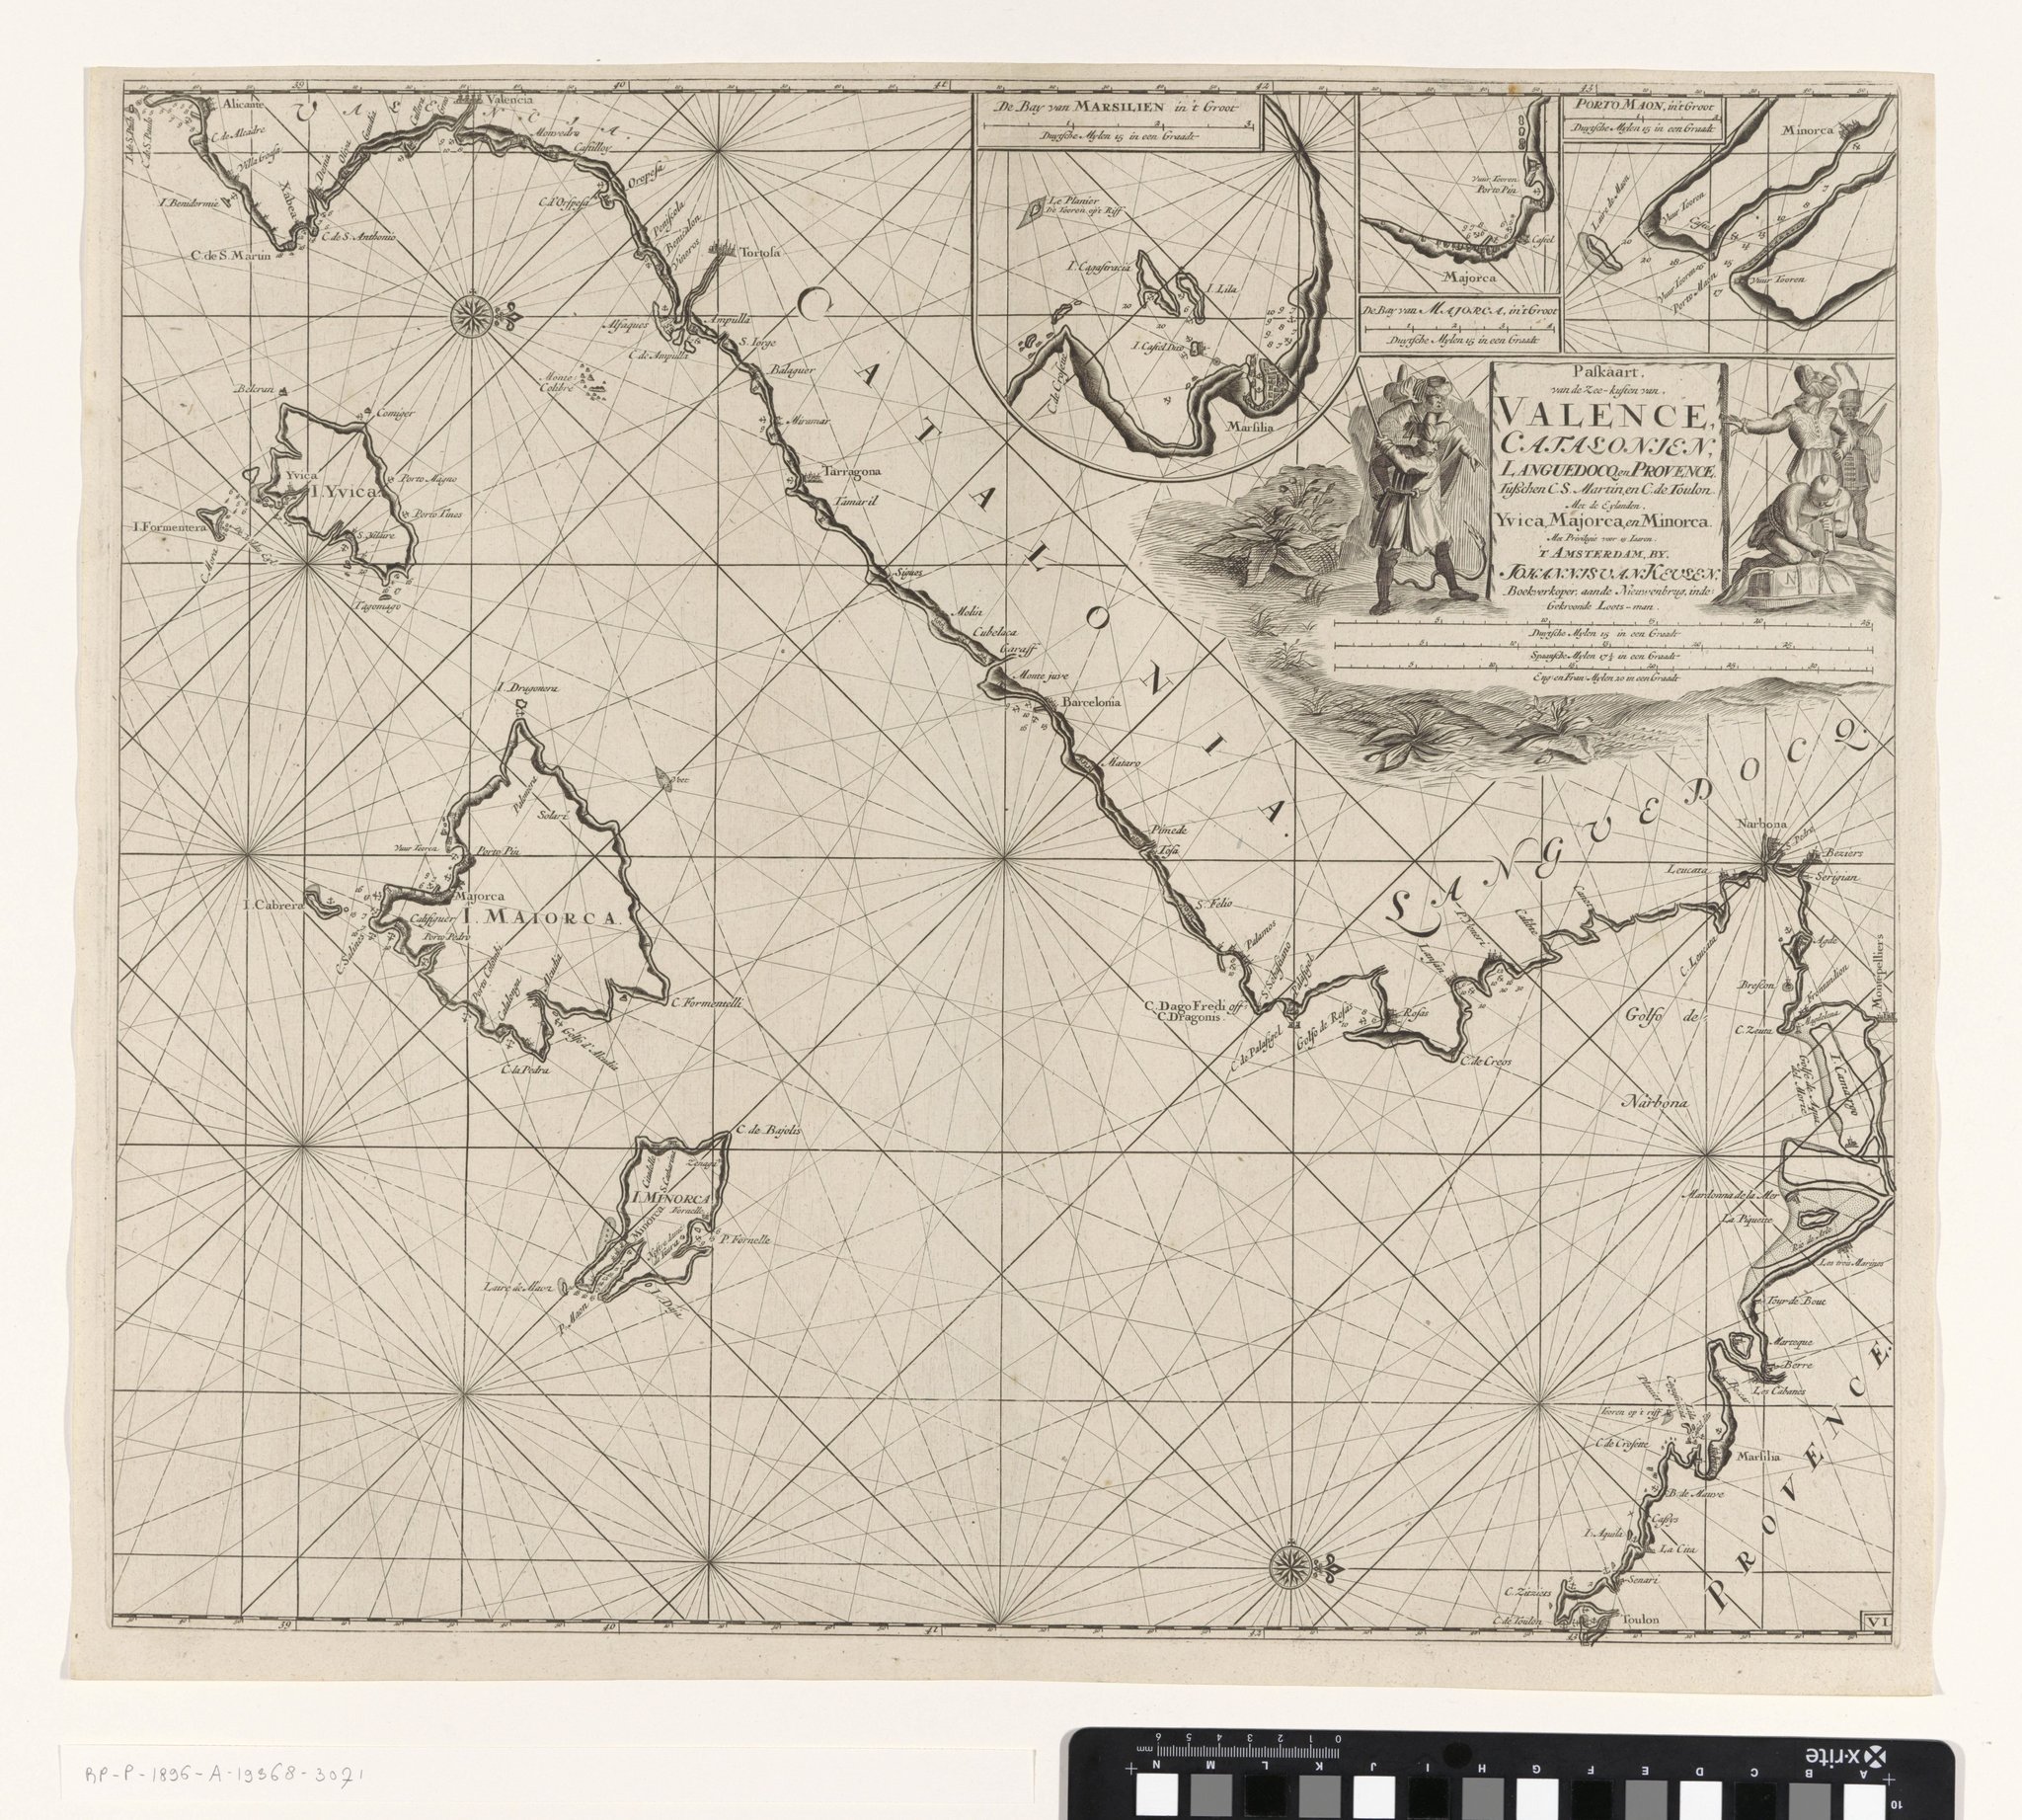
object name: print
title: Paskaart van de Zee-kusten van Valence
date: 1682-1803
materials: paper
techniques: engraving, etching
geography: amsterdam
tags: snakes, head-gear: turban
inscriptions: collector's mark: Lugt 2228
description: Paskaart van een gedeelte van de oostkust van Spanje met de Balearen en een deel van de Franse kust, met drie inzetkaarten en met twee kompasrozen, het Noorden ligt rechts. Rechtsboven een cartouche met de titel, het adres van de uitgever en de schaalverdeling, weergegeven in Duitse, Spaanse en Engelse of Franse mijlen (schaal: c. 1:1.100.000). De titel wordt geflankeerd door oosterse figuren.